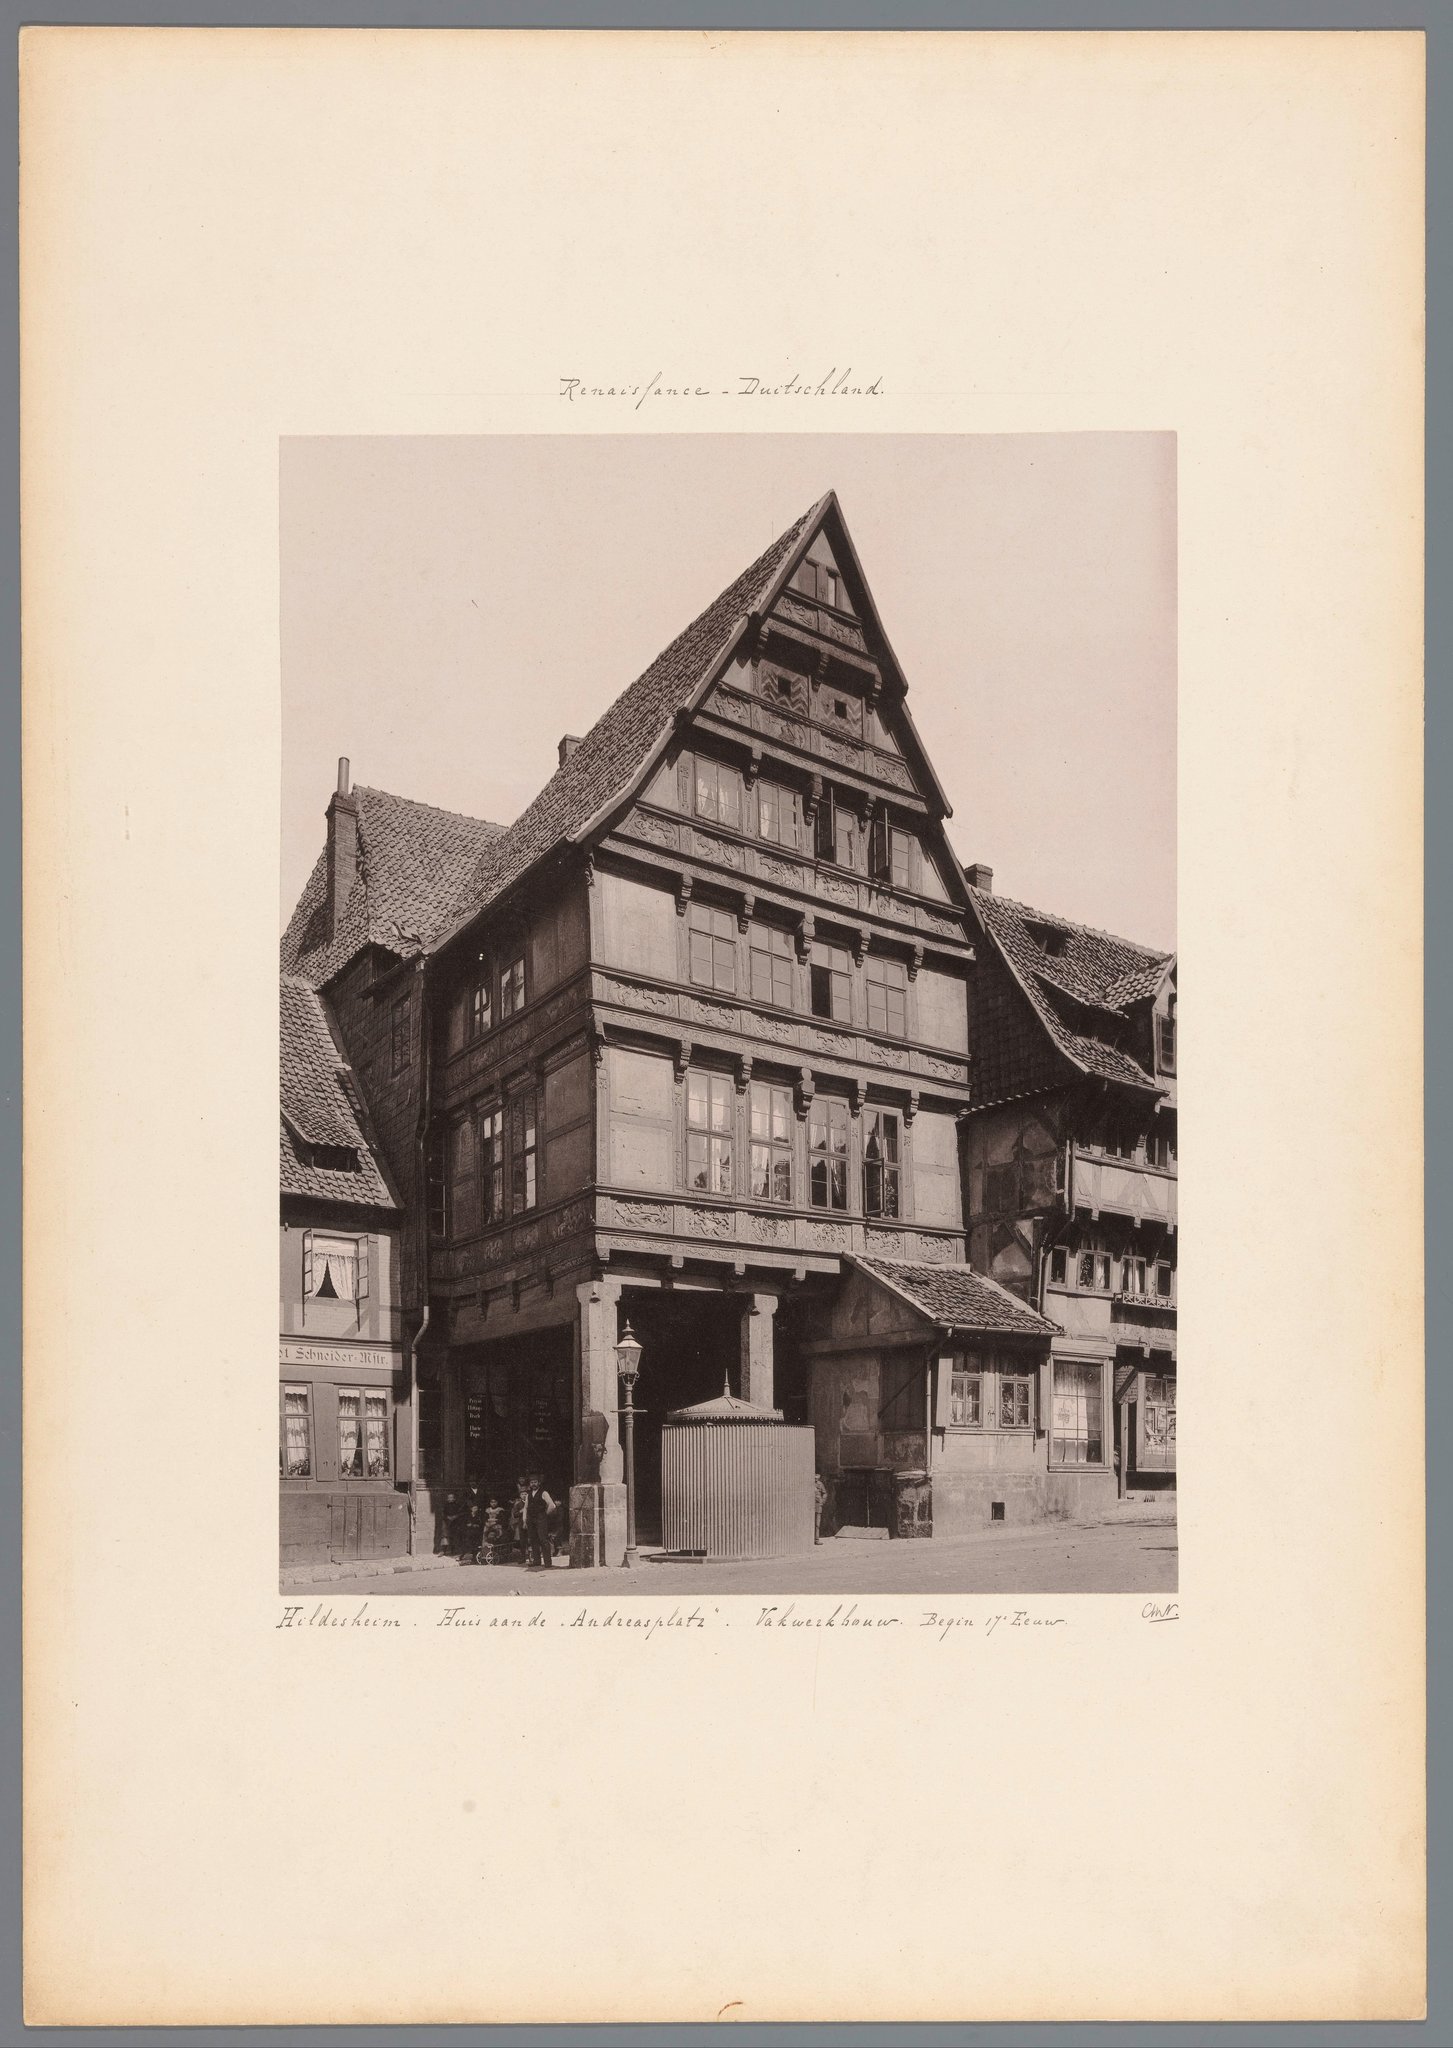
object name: photograph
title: Gezicht op een vakwerkhuis aan de Andreasplatz te Hildesheim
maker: Anonymous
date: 1875-1900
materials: cardboard, paper, ink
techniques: photograph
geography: hildesheim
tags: urban housing, street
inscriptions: collector's mark: ‘KUNSTNIJVERHEIDSCHOOL QUELLINUS AMSTERDAM FRANS HALSSTRAAT 14.’, collector's mark: ‘INSTITUUT VOOR KUNST-NIJVERHEIDSONDERWIJS GABRIËL METSUSTRAAT No. 16 AMSTERDAM’, inscription: ‘CWN.’, inscription: ‘Renaissance - Duitschland.’